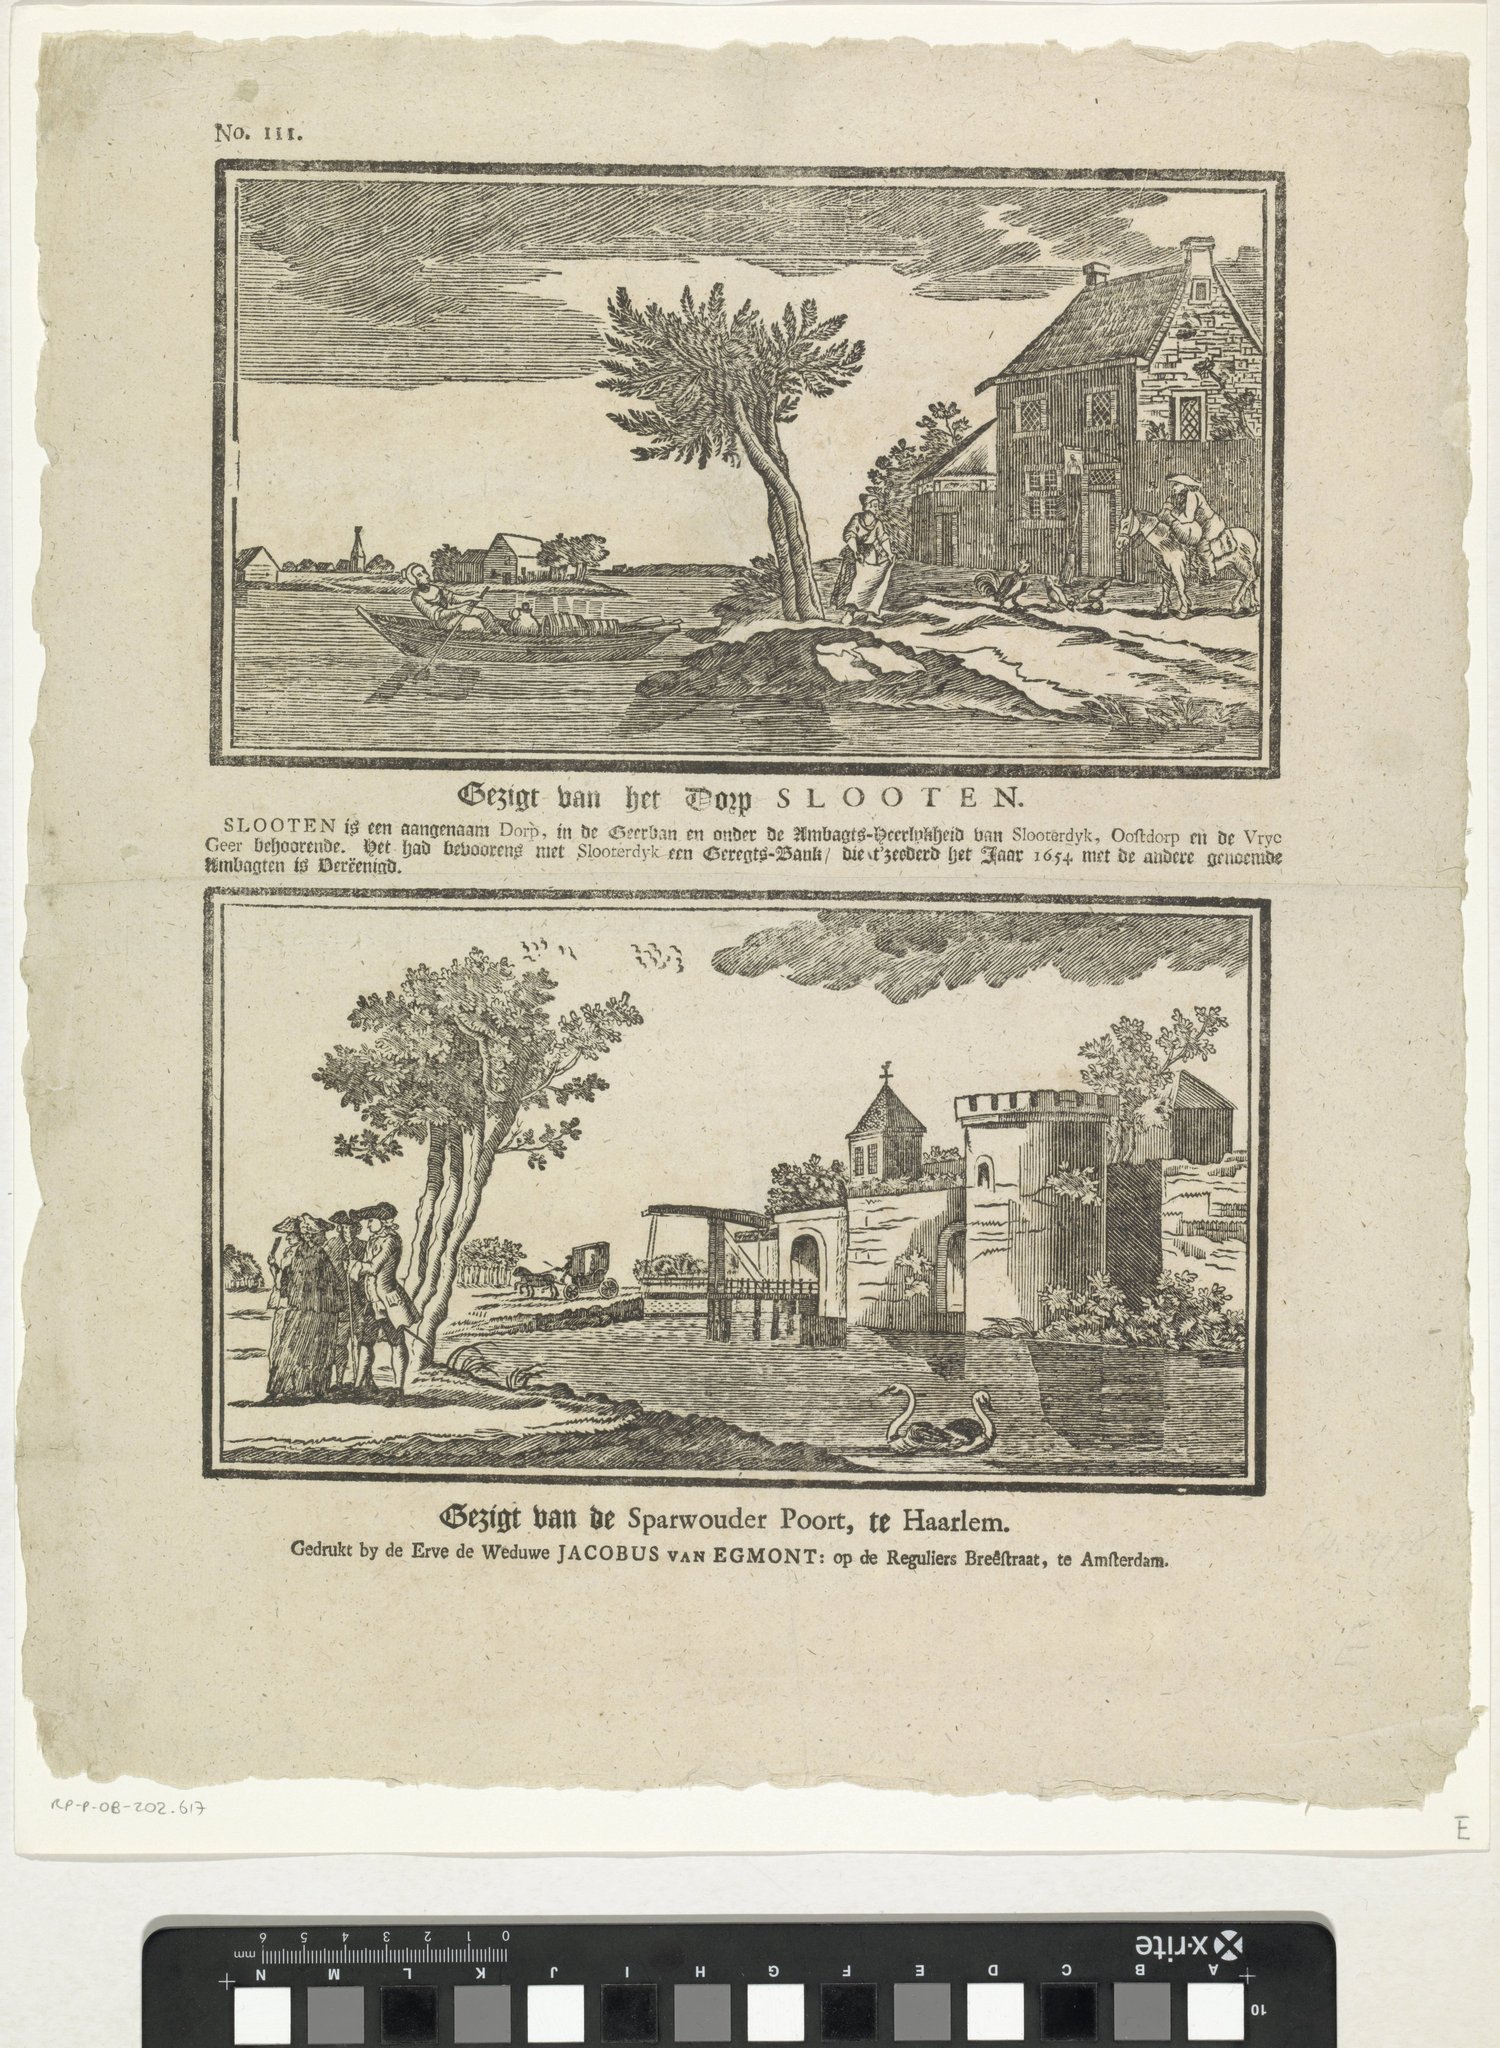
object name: print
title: Gezigt van het dorp Slooten / Gezigt van de Sparwouder Poort, te Haarlem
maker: Anonymous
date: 1761-1804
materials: paper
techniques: letterpress printing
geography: amsterdam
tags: city-view, and landscape with man-made constructions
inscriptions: collector's mark: Lugt 2760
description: Blad met 2 voorstelling. Boven: een gezicht op Sloten. Onder: een gezicht op de Spaarnwouderpoort te Haarlem. Onder elke voorstelling een titel en een onderschrift. Genummerd linksboven: No. 111.